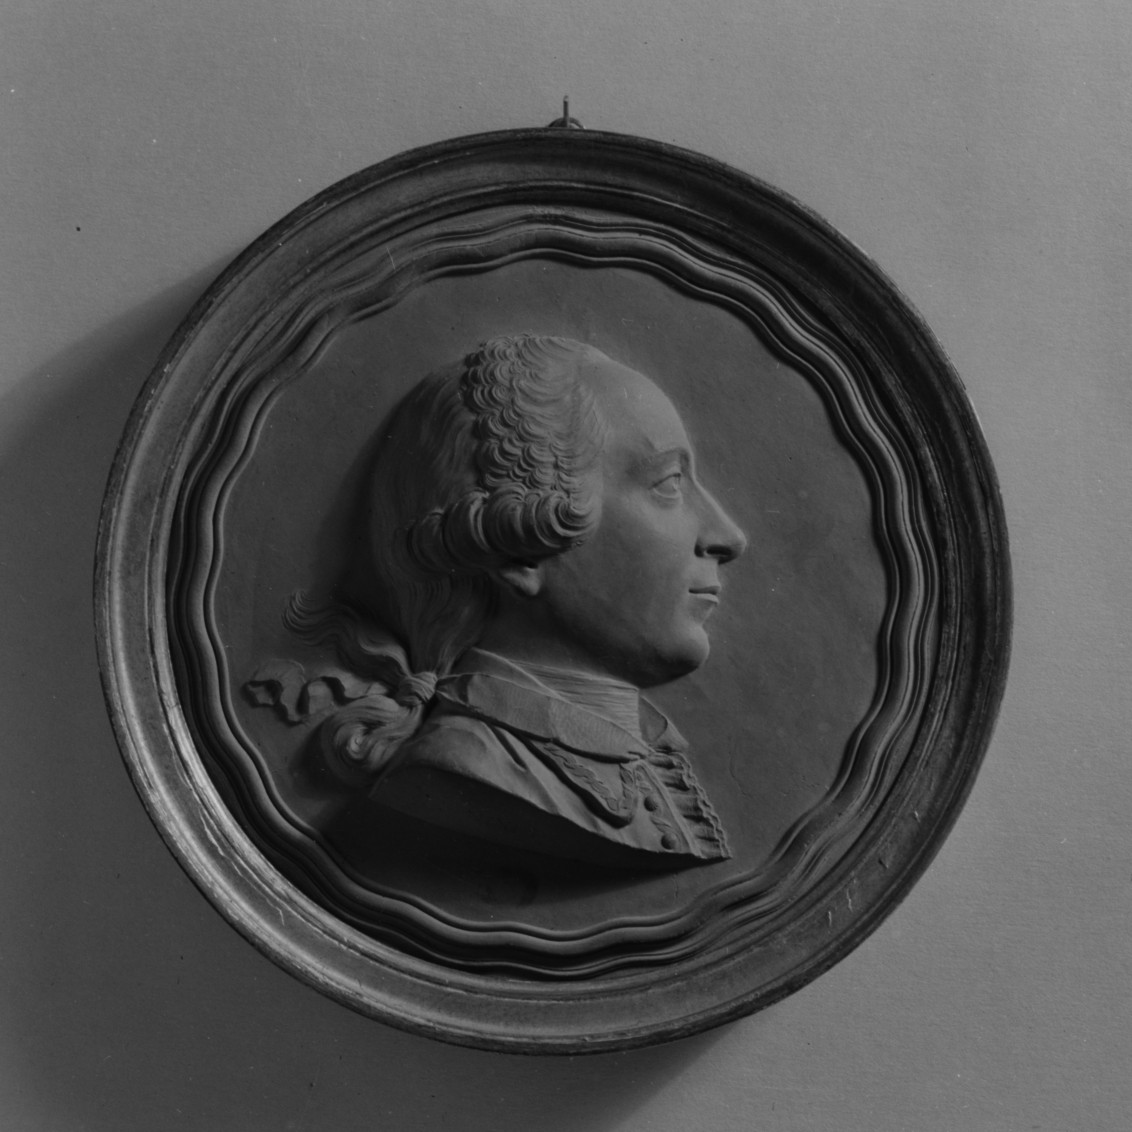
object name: medallion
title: Portrait of a man, possibly the Marquis de Riancey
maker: jean-baptiste nini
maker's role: artist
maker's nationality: italian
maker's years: 1717-1786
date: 1763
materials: gilt, terracotta, wood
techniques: casting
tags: men,profiles